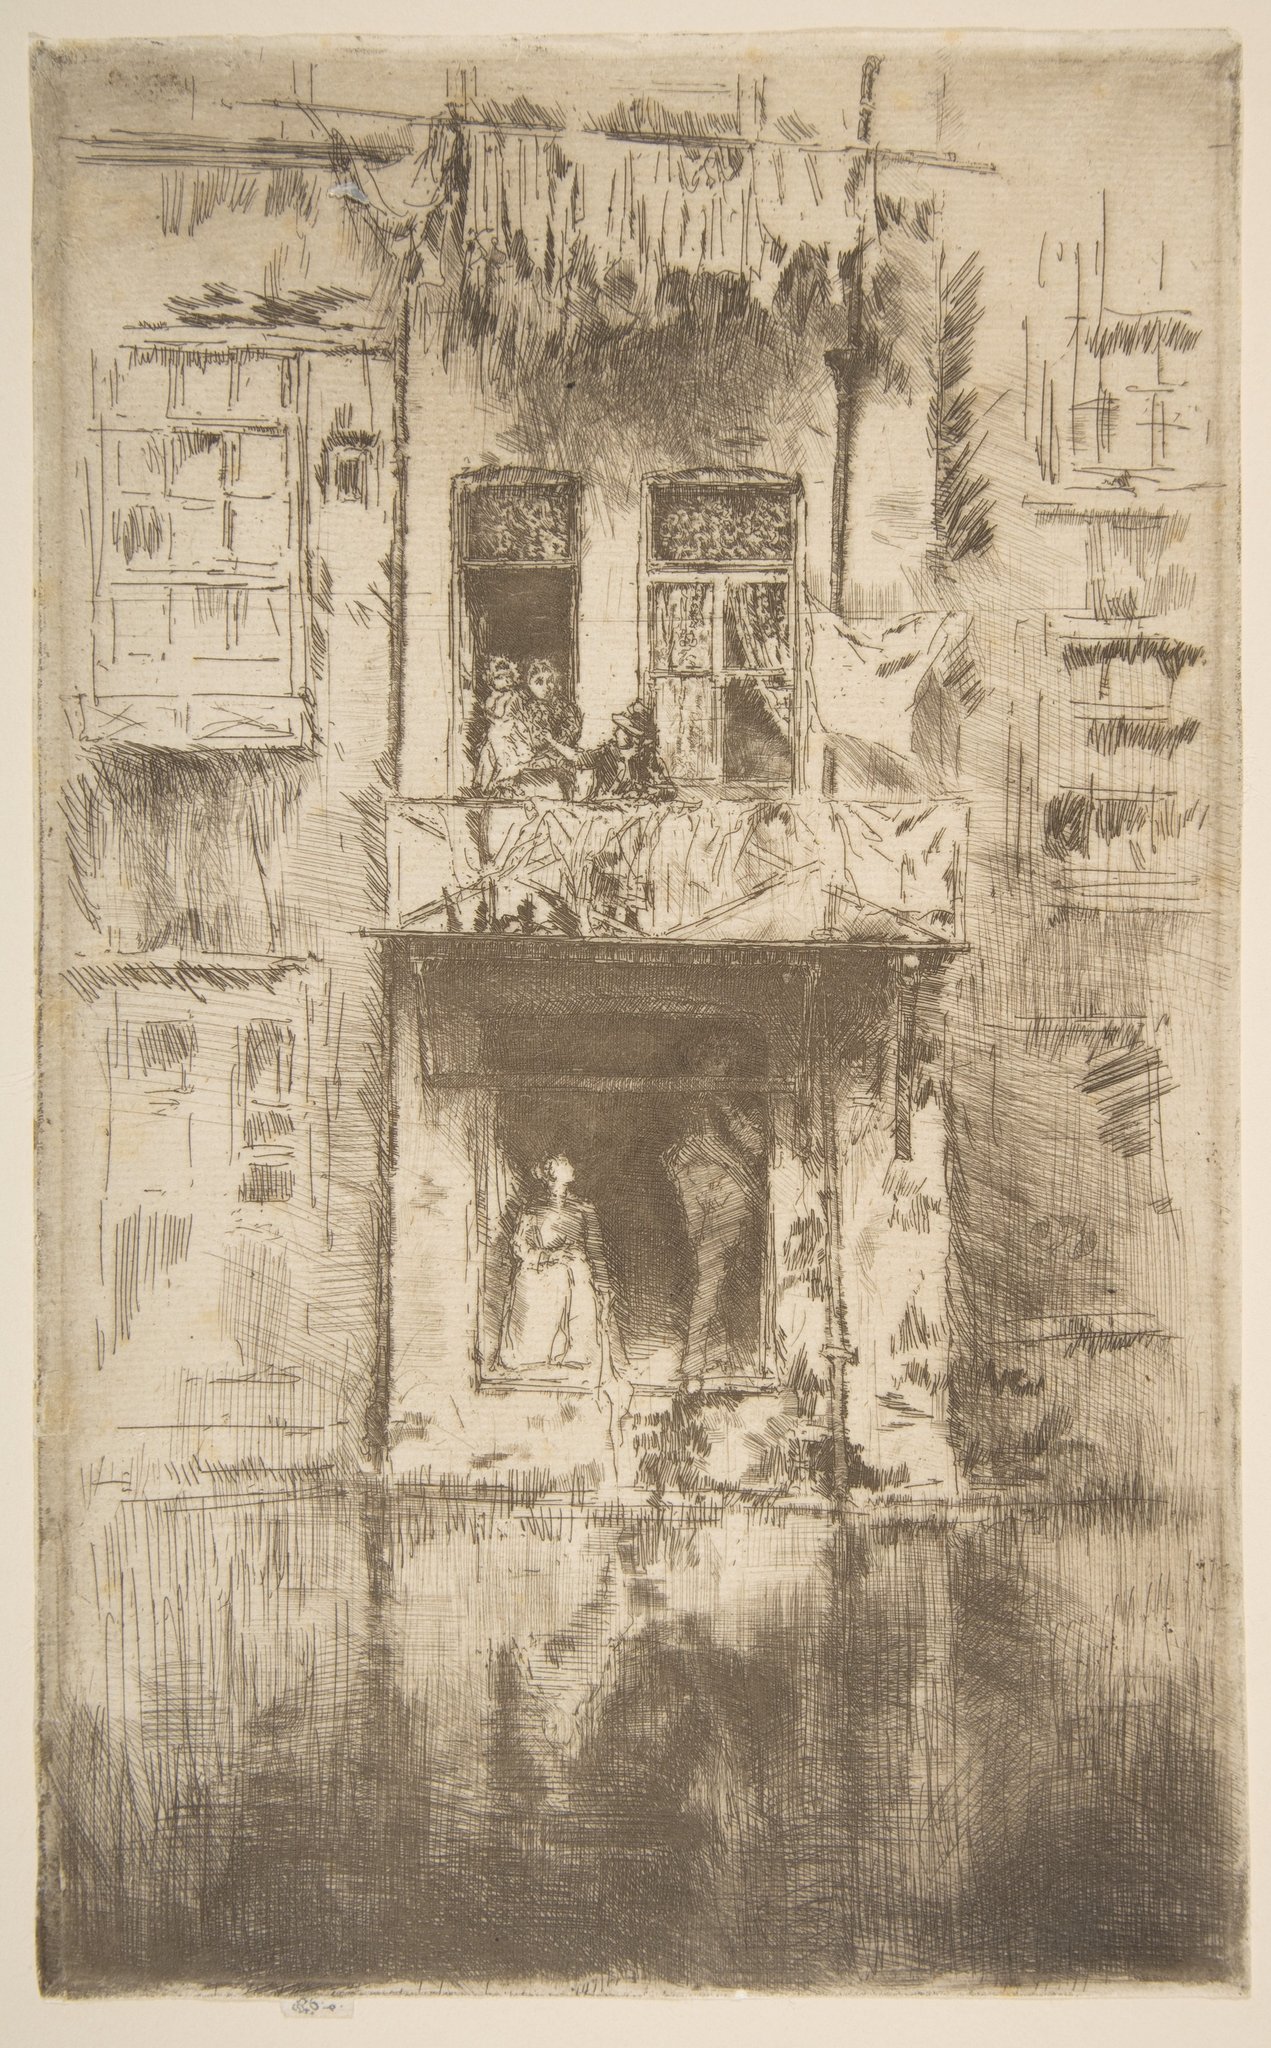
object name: print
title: Balcony, Amsterdam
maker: james mcneill whistler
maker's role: artist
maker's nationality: american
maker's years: 1834-1903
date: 1889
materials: ink, ivory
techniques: drypoint, etching, printing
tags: balconies,houses,amsterdam